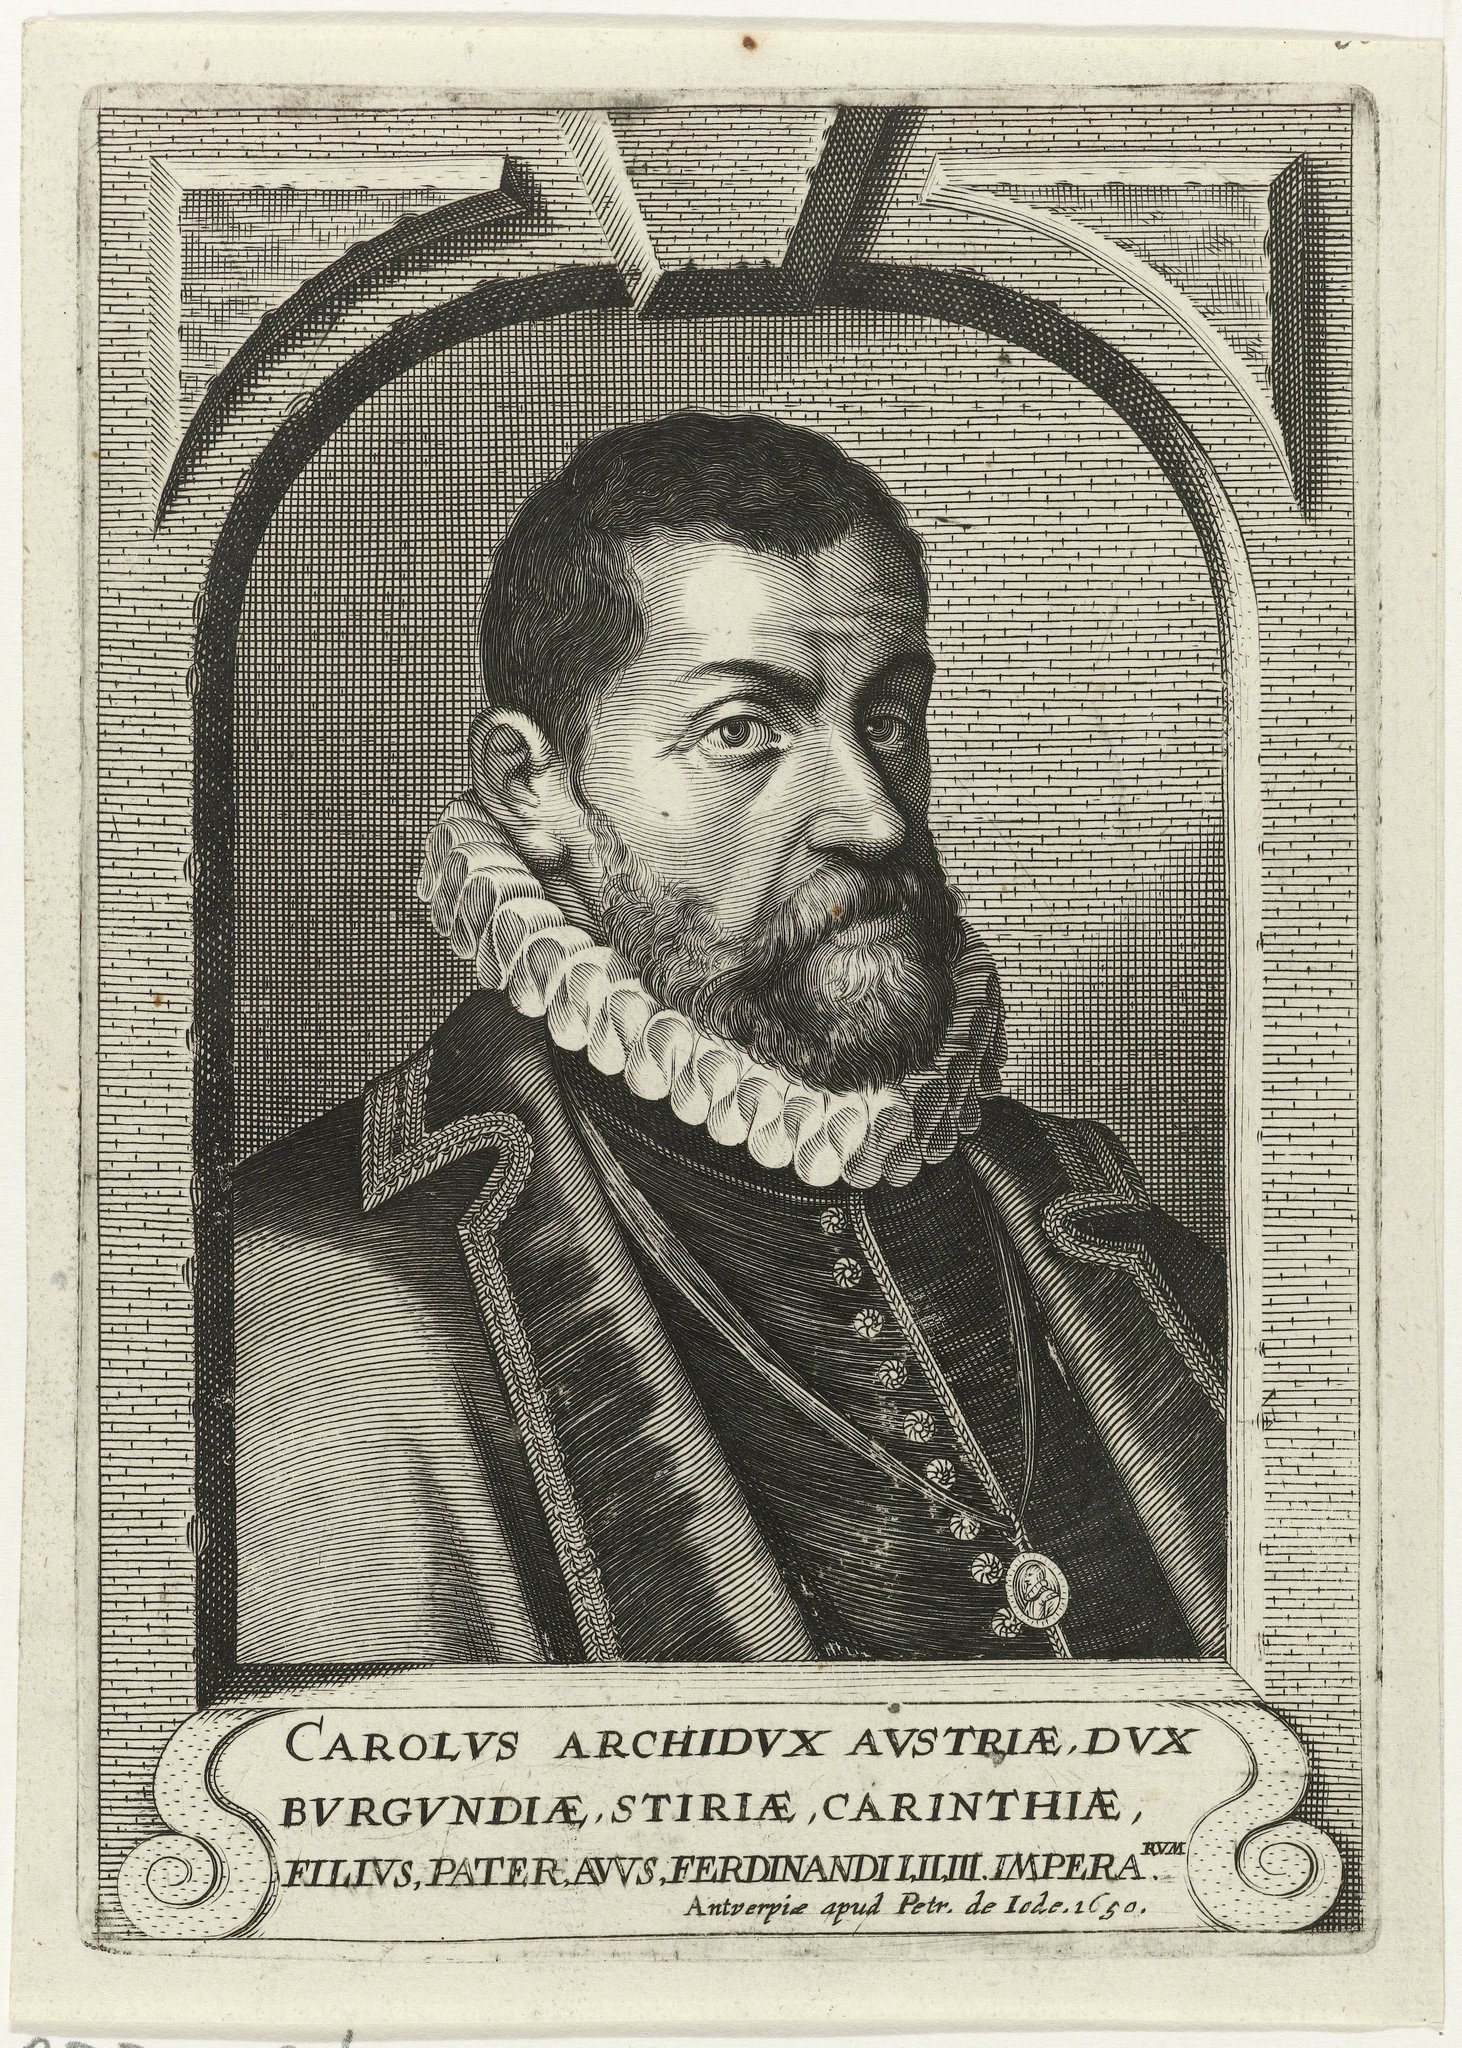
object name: print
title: Theatrum pontificum, imperatorum, regum, ducum, principum, etc.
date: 1650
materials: paper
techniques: engraving, etching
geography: antwerp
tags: vienna, karel ii (aartshertog van binnen-oostenrijk)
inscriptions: collector's mark: Lugt 2228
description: Portret van Karel II, hij draagt een lint met een portretmedaillon. Het portret is gevat in een boogvormige omlijsting. In het kader een drieregelig onderschrift in het Latijn.